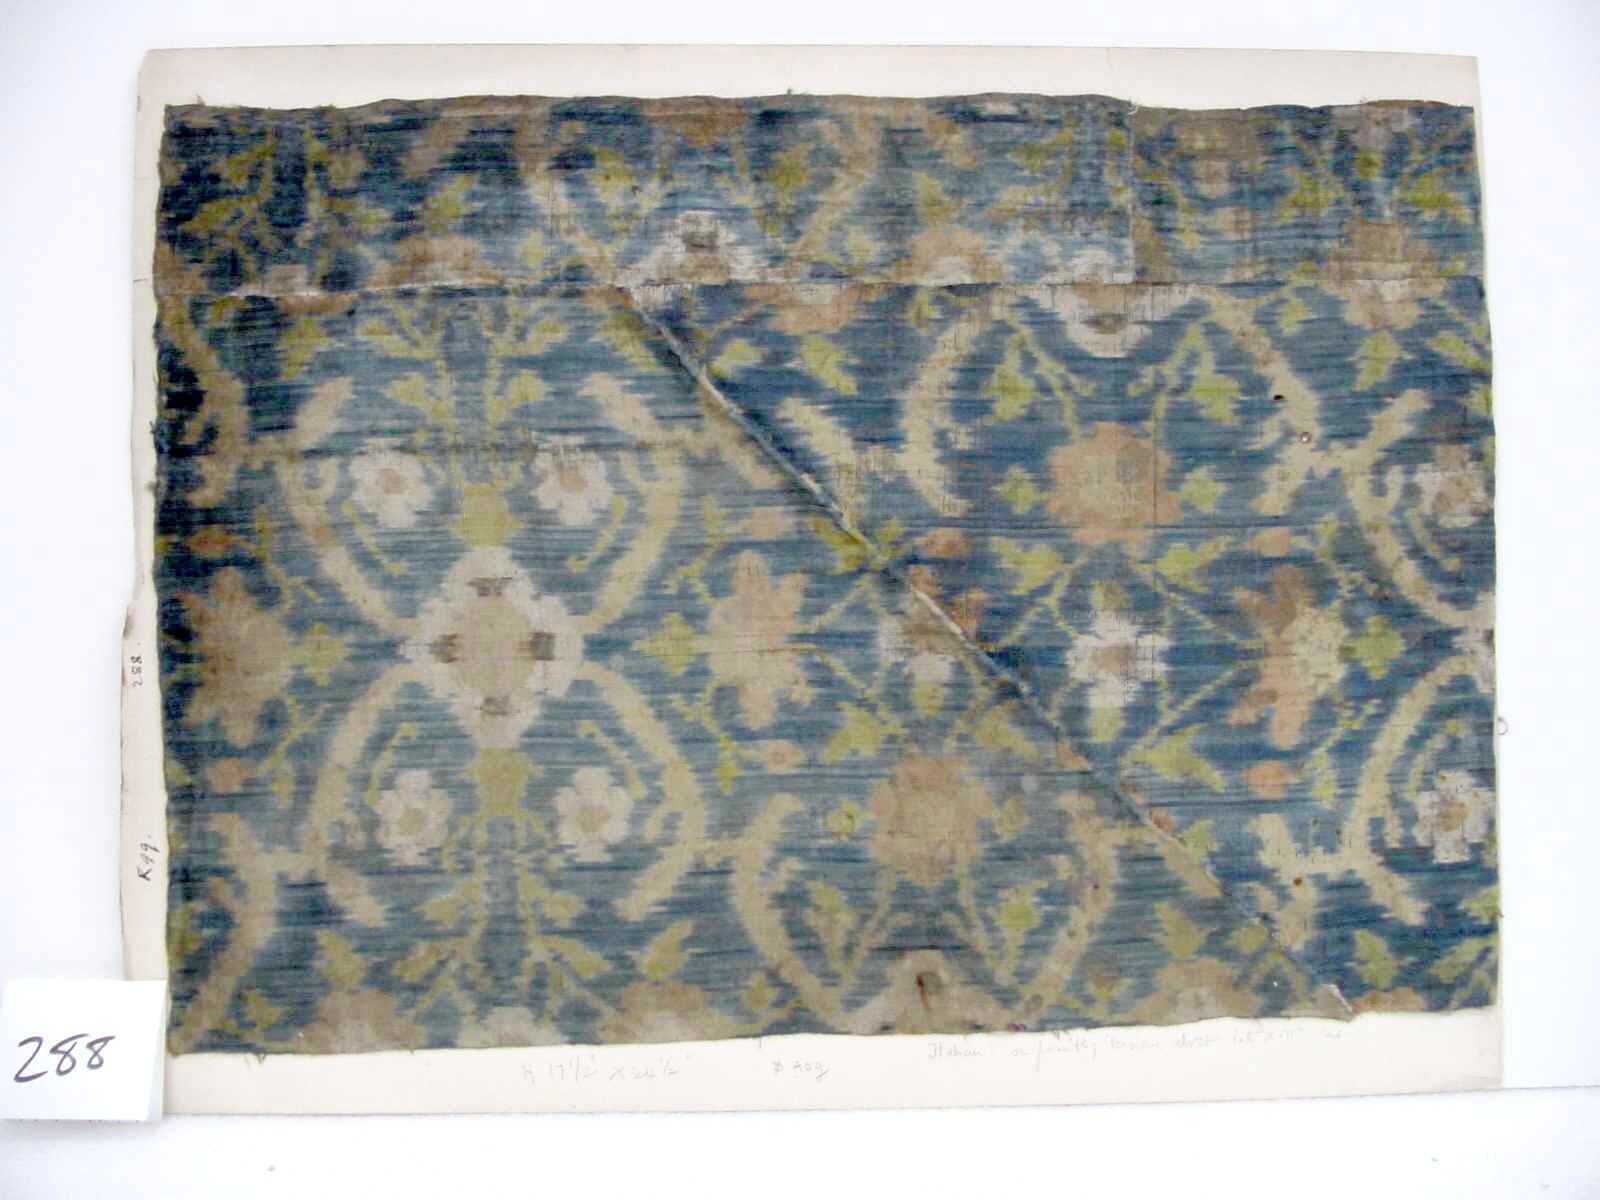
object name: textile fragment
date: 1601-1800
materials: silk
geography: iran